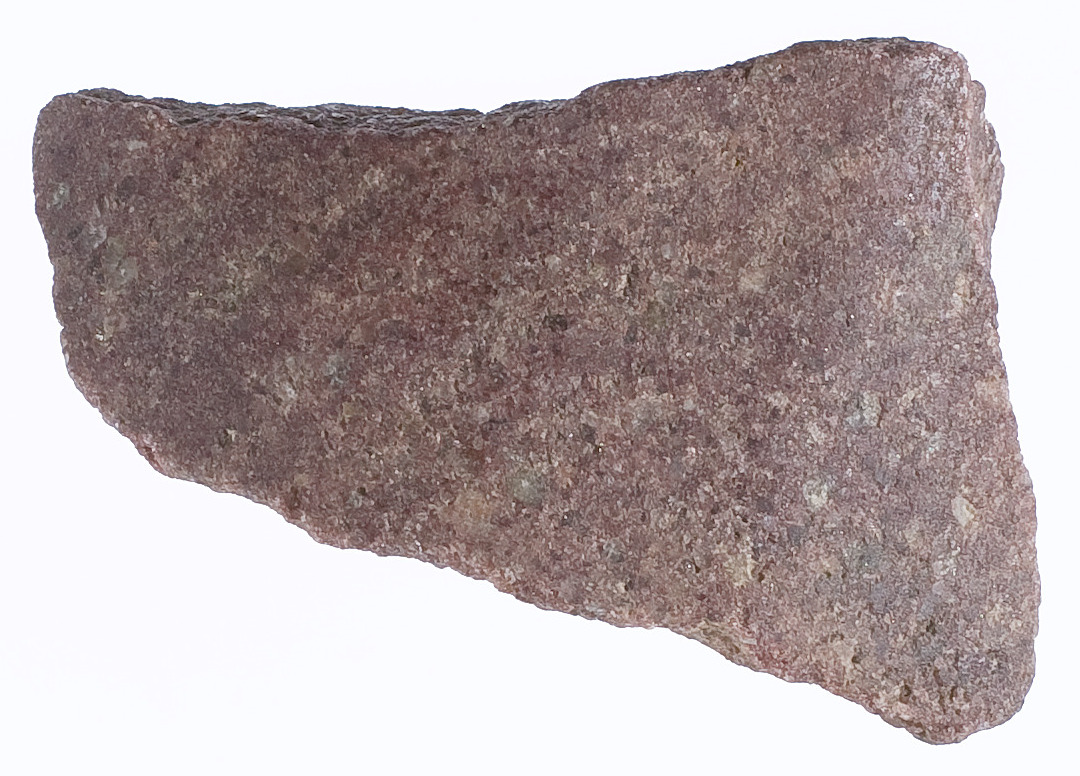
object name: limb, garment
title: limb fragment with faint garment pleats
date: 1353-1336 BCE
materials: quartzite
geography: egypt